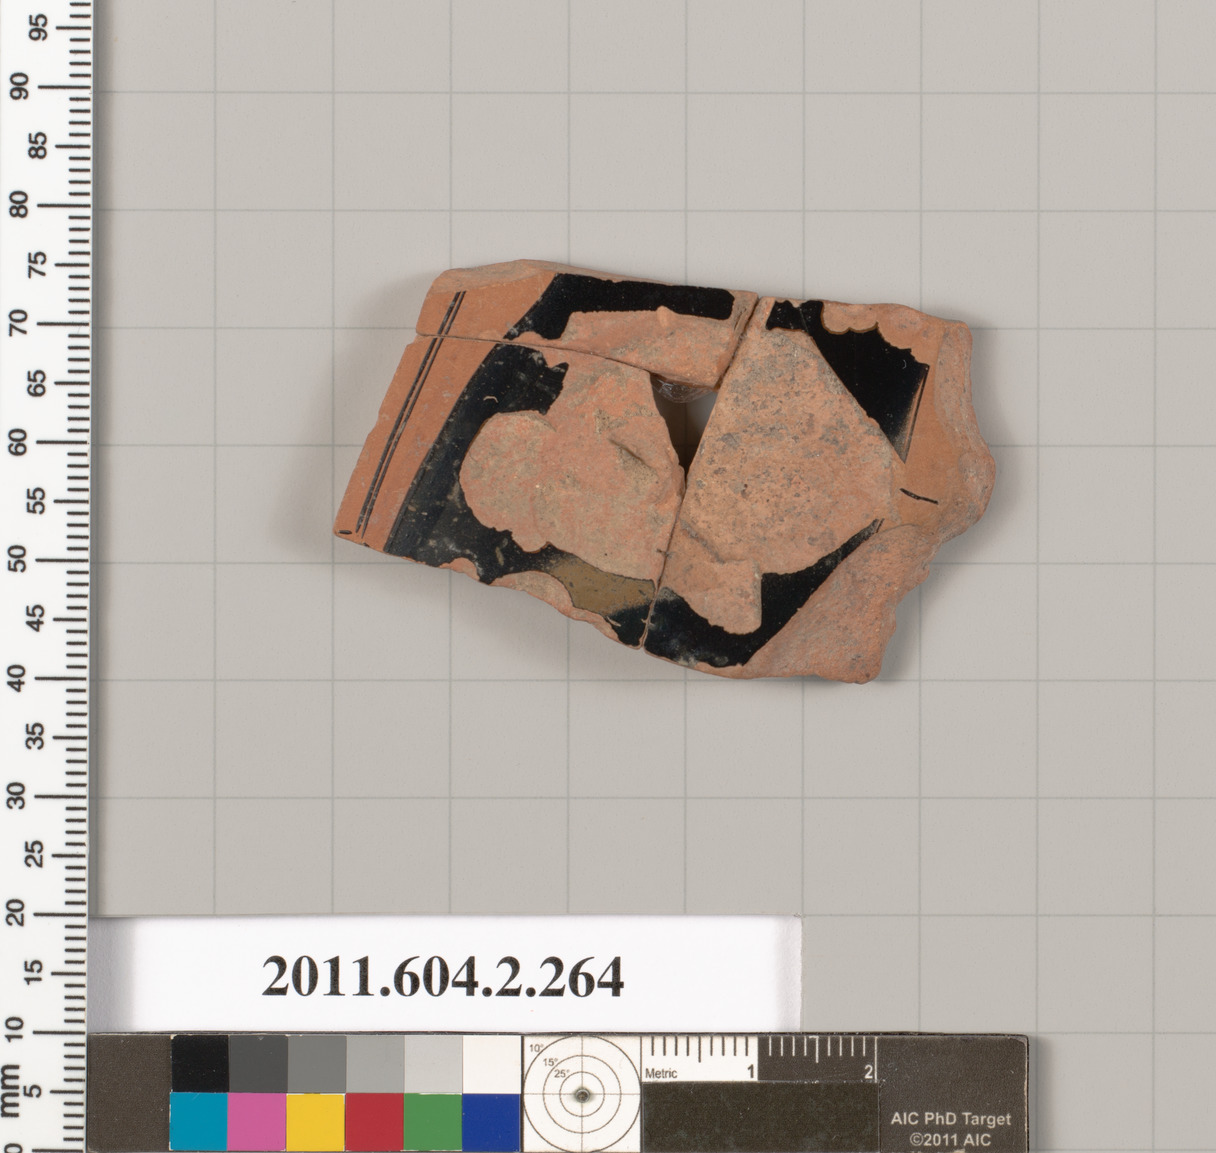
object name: stamnos fragment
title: Terracotta fragment of a stamnos (jar)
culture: greek, attic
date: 490-470 BCE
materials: terracotta